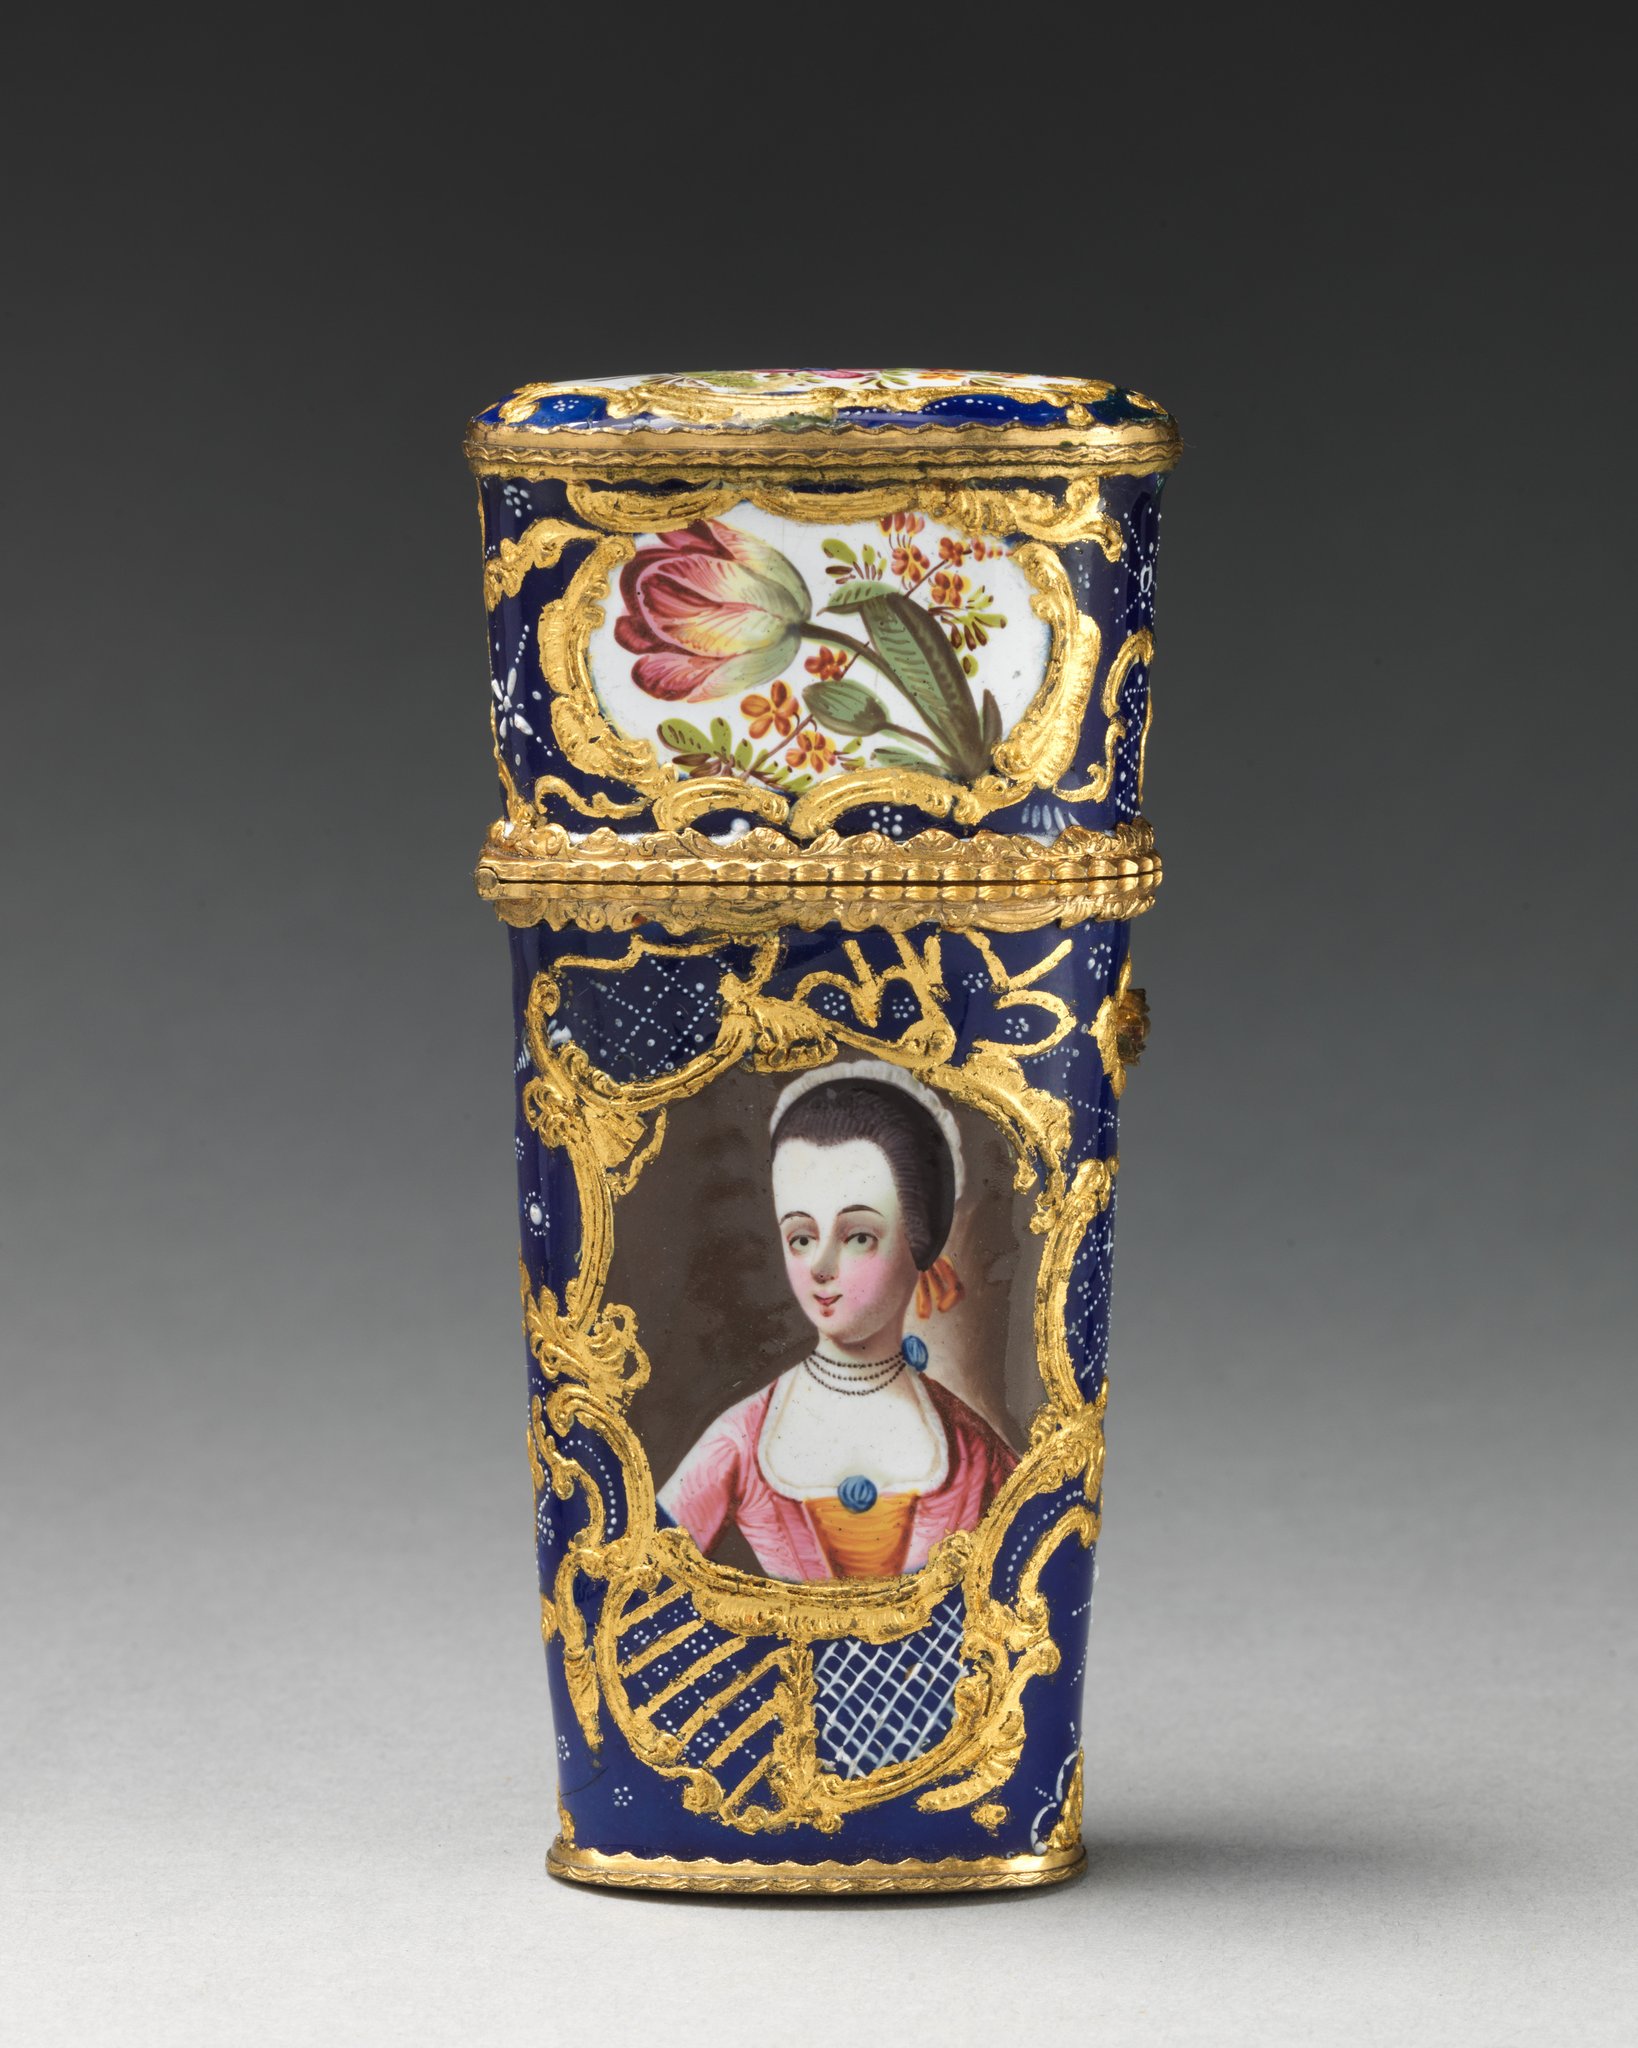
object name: étui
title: Étui with unidentified portraits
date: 1765-1770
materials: copper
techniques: enamel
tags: portraits,women,flowers